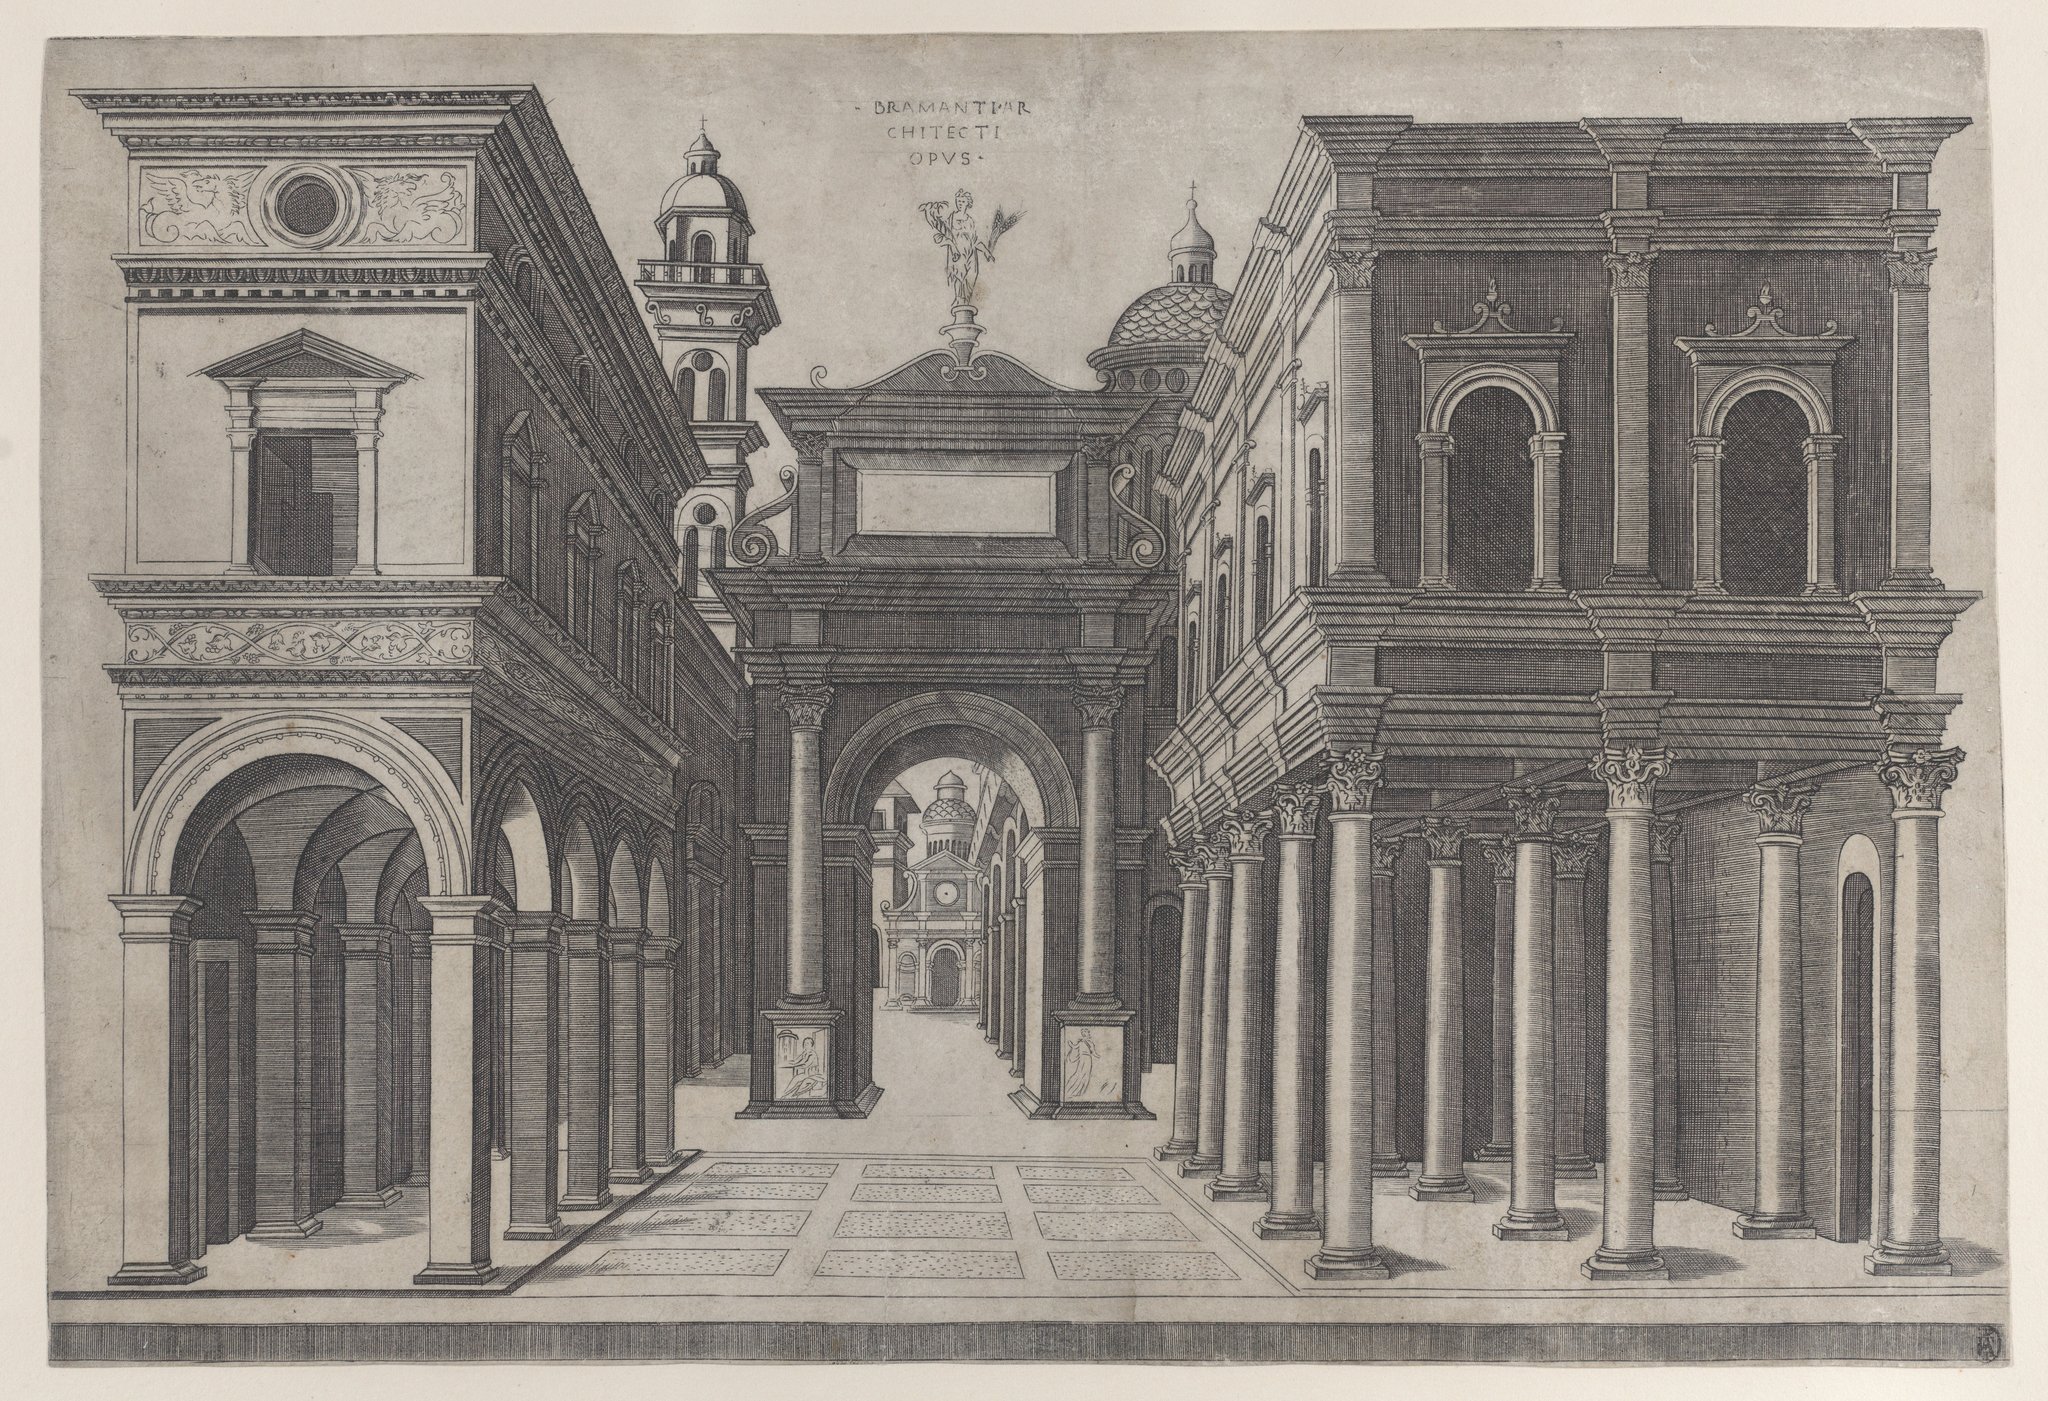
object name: print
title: A street with various buildings, colonnades and an arch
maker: donato d'agnolo bramante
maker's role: artist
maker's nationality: italian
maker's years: 1444-1515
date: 1475-1510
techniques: engraving